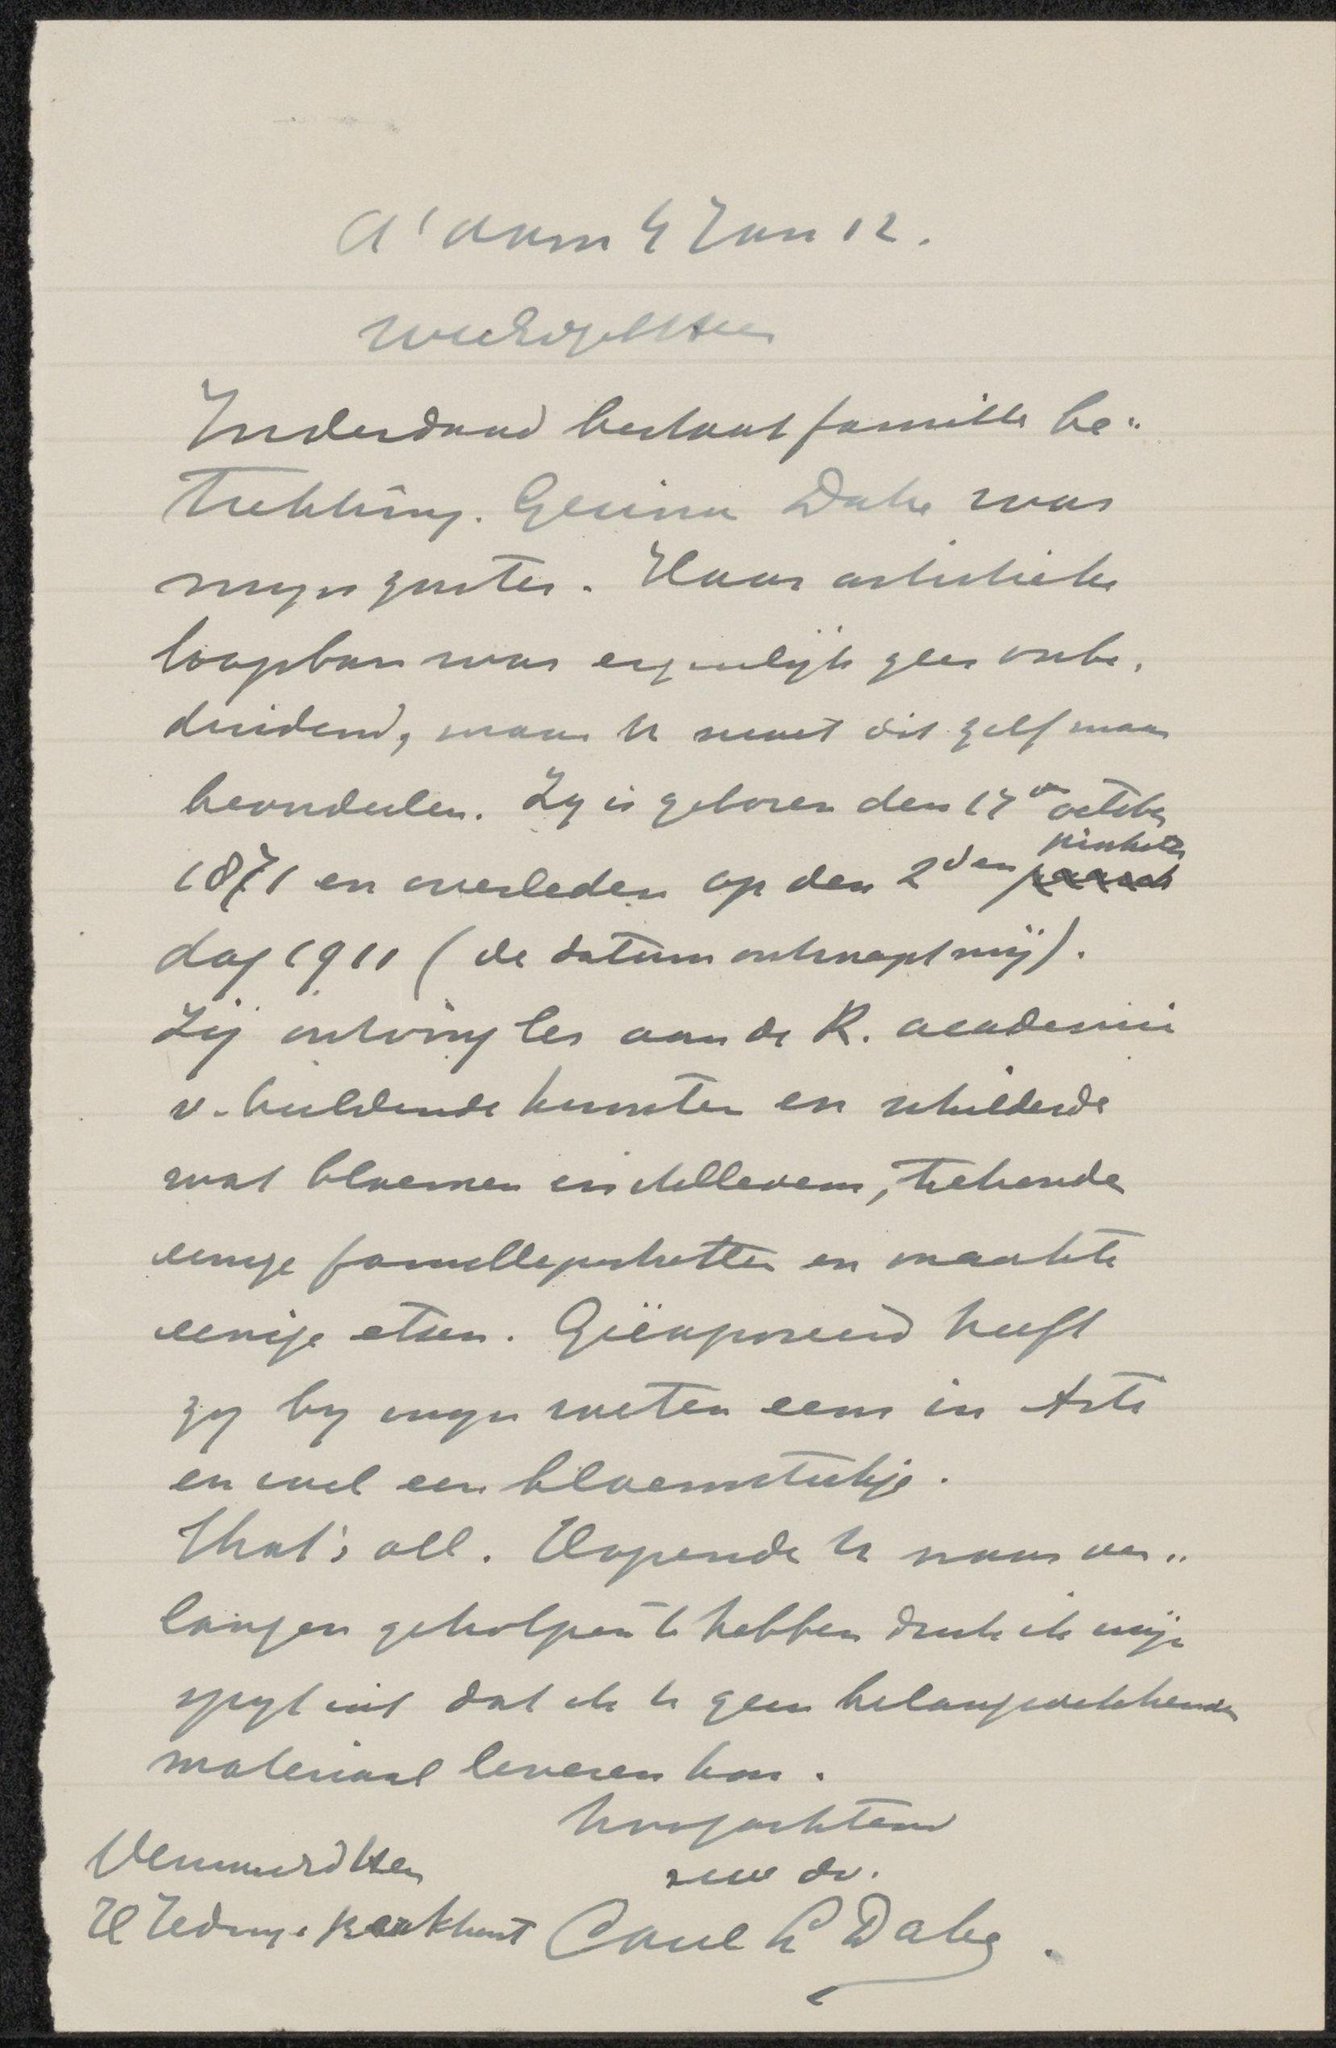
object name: letter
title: Brief aan Frans Buffa en Zonen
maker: carel lodewijk dake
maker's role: draughtsman, painter, print maker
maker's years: 1857-1918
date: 1912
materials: ink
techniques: pen, writing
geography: amsterdam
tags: publisher, gesina dake, drawing, the graphic arts, painting (including book-illumination, miniature-painting), exhibition ~ art, historical persons (portraits and scenes from the life)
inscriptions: collector's mark: Lugt 2233